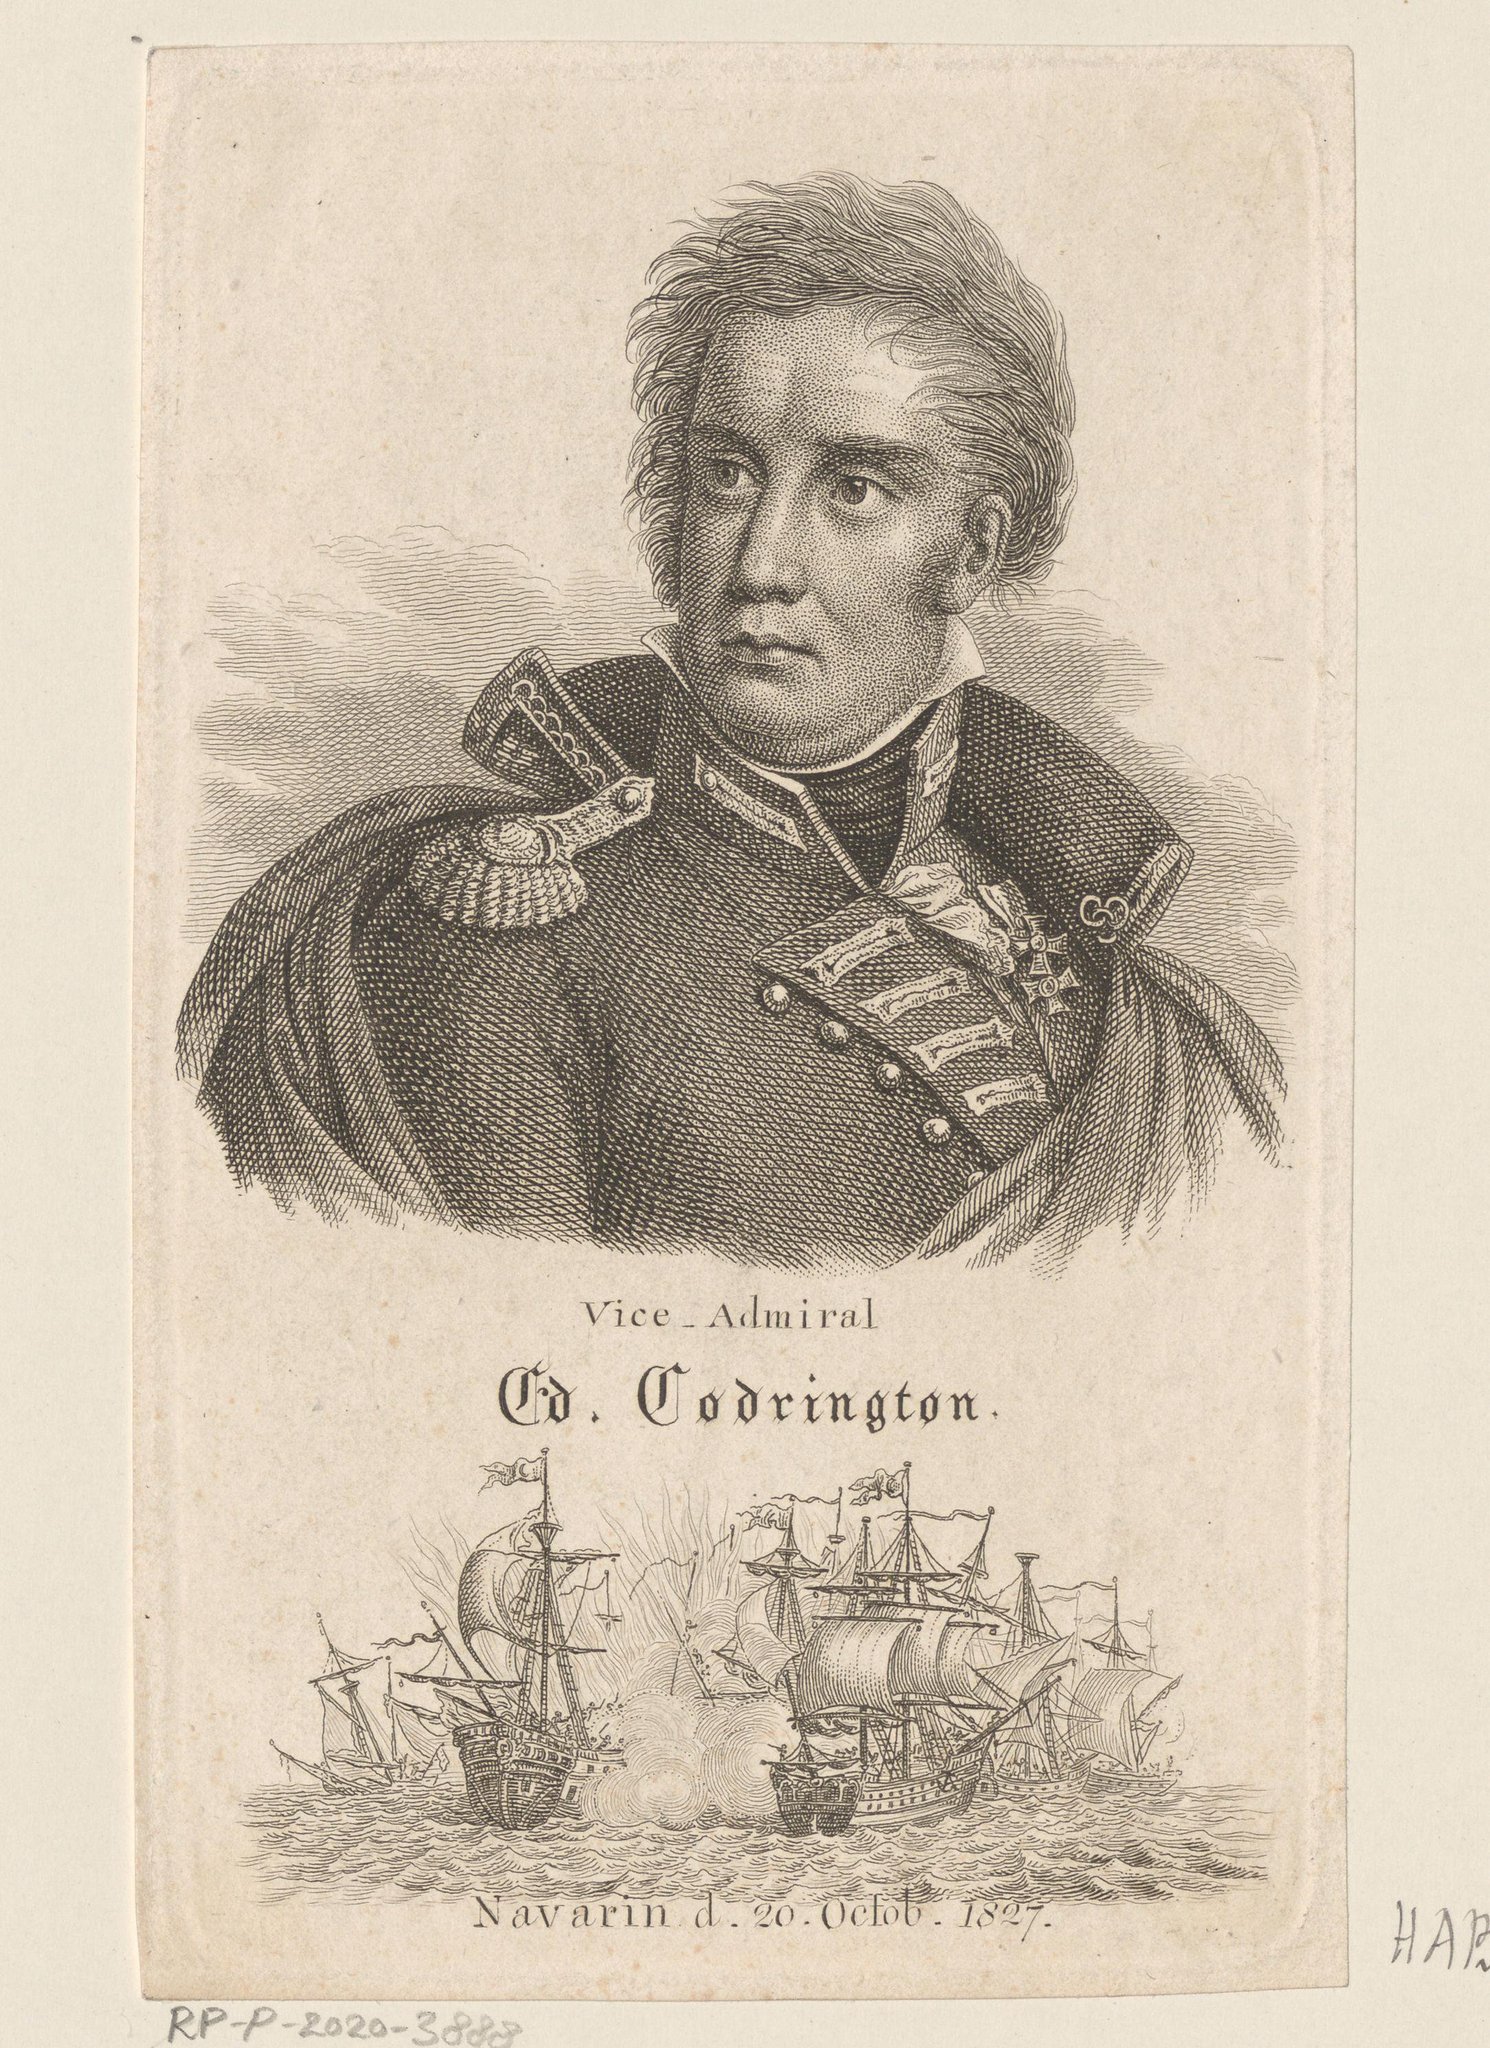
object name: print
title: Portret van Sir Edward Codrington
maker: Anonymous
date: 1827-1899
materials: paper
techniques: etching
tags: historical persons, battle